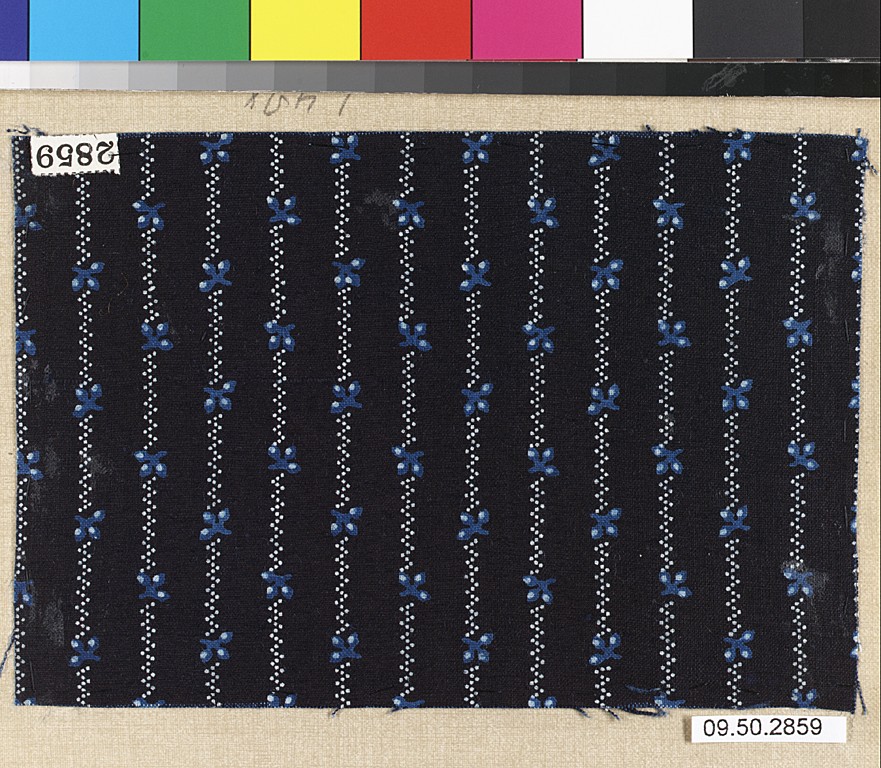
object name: piece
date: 1801-1900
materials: cotton